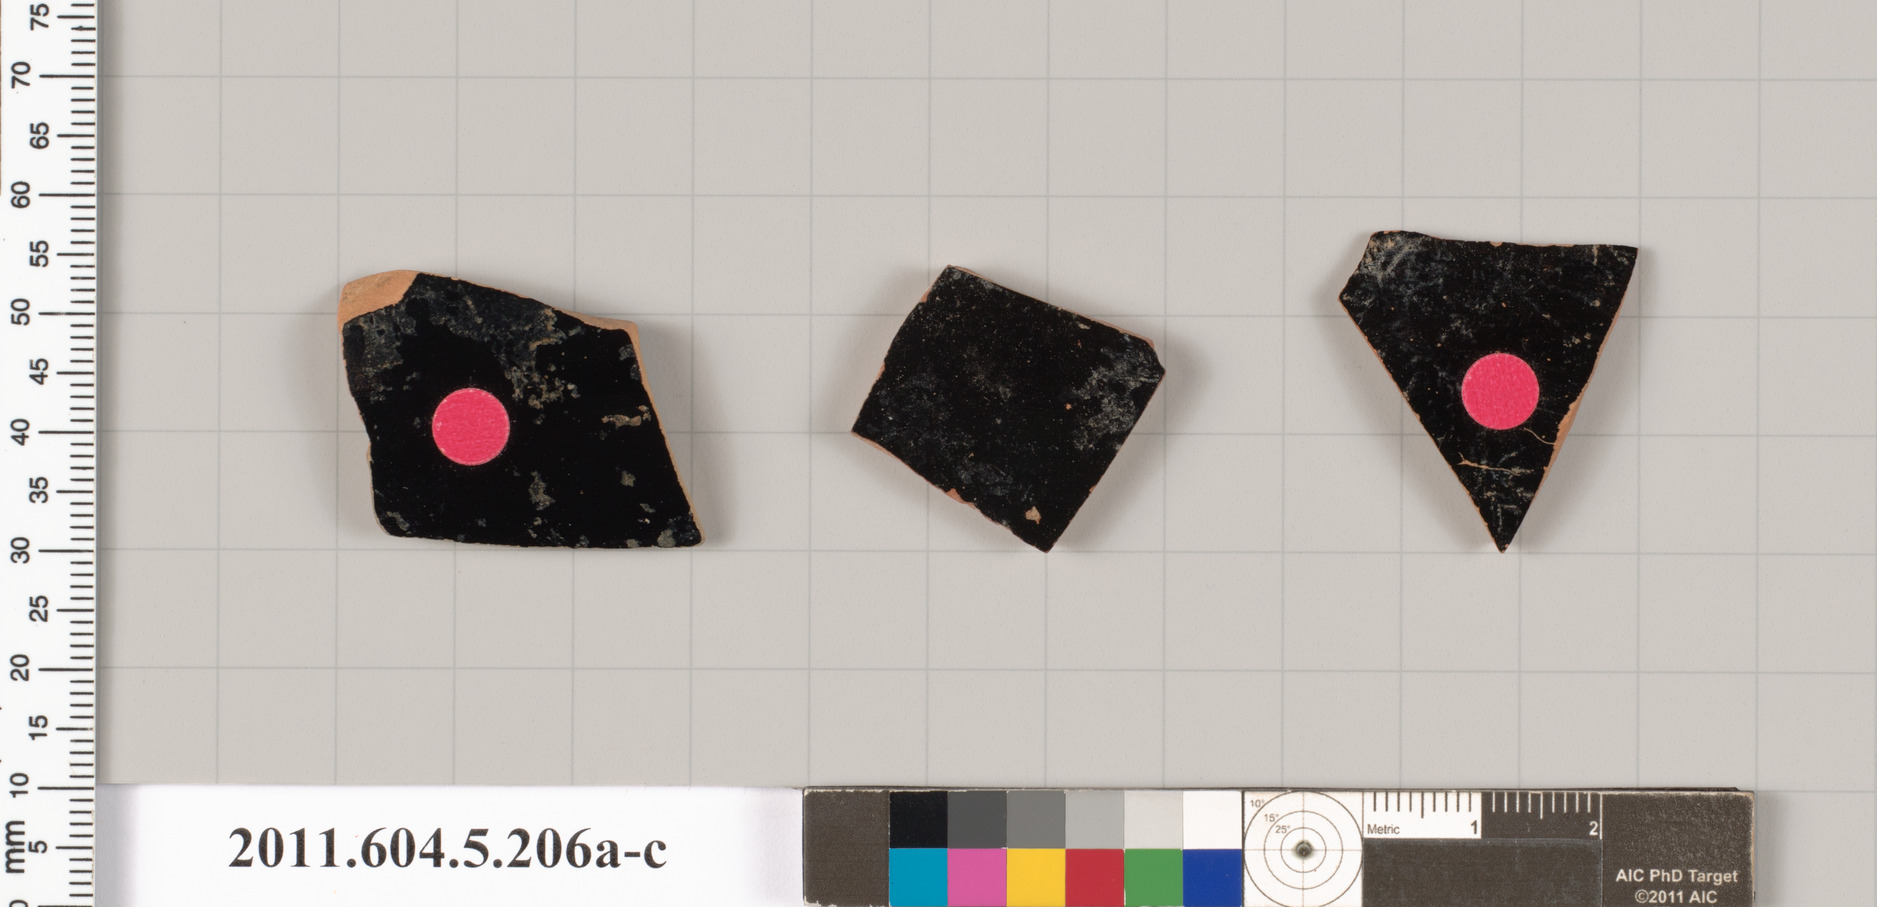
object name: kylix fragment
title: Terracotta fragments of kylikes (drinking cups)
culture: greek, attic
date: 600-401 BCE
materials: terracotta